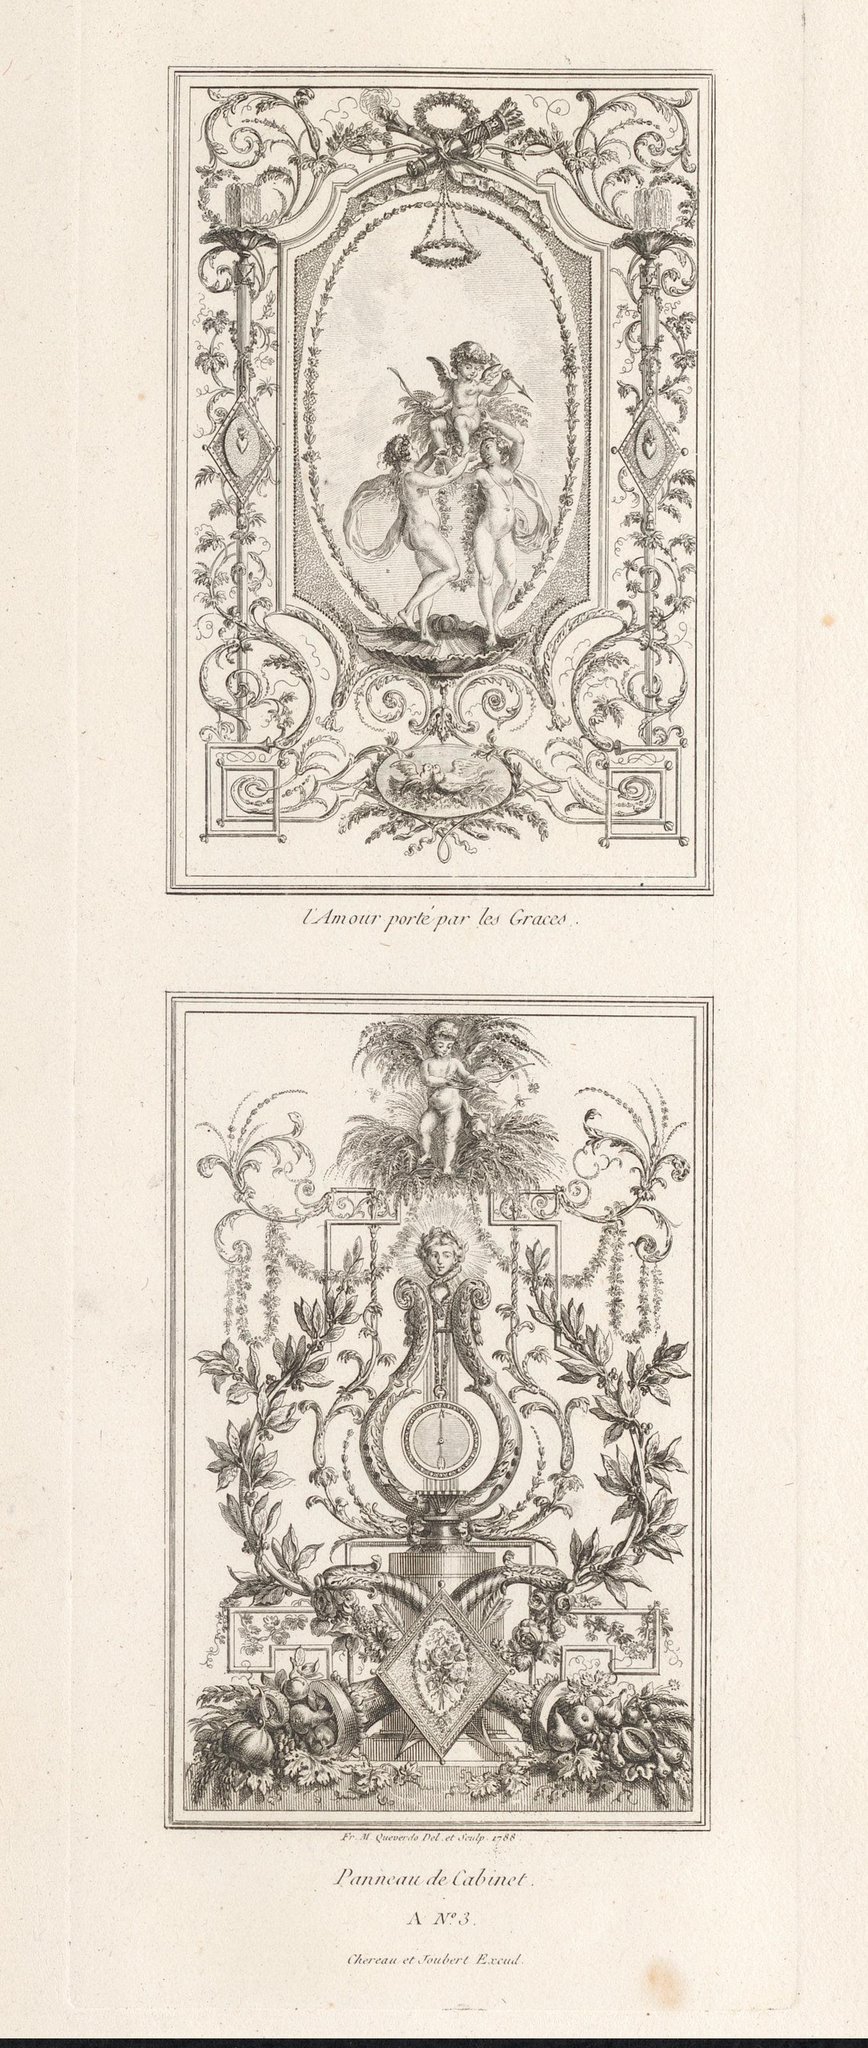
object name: print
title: L'amour porté par les Graces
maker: françois marie isidore queverdo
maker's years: 1748-1797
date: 1788-1802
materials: paper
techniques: etching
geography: paris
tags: 'cornucopia', horn of plenty, ornament ~ arabesque, graces (charites), generally three in number; 'gratie' (ripa), cupids: 'amores', 'amoretti', 'putti'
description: Doordat dit album bestaat uit meerdere, deels eerder uitgegeven prentreeksen, is de datering niet consequent. Het geheel is op de titelpagina gedateerd op 1802. Deze reeks is gedateerd op 1788. De serietitel voor het gehele werk is "Recueil d'arabesques, contenant les loges du Vatican". De andere serietitel is de titel van de specifieke reeks binnen het geheel.